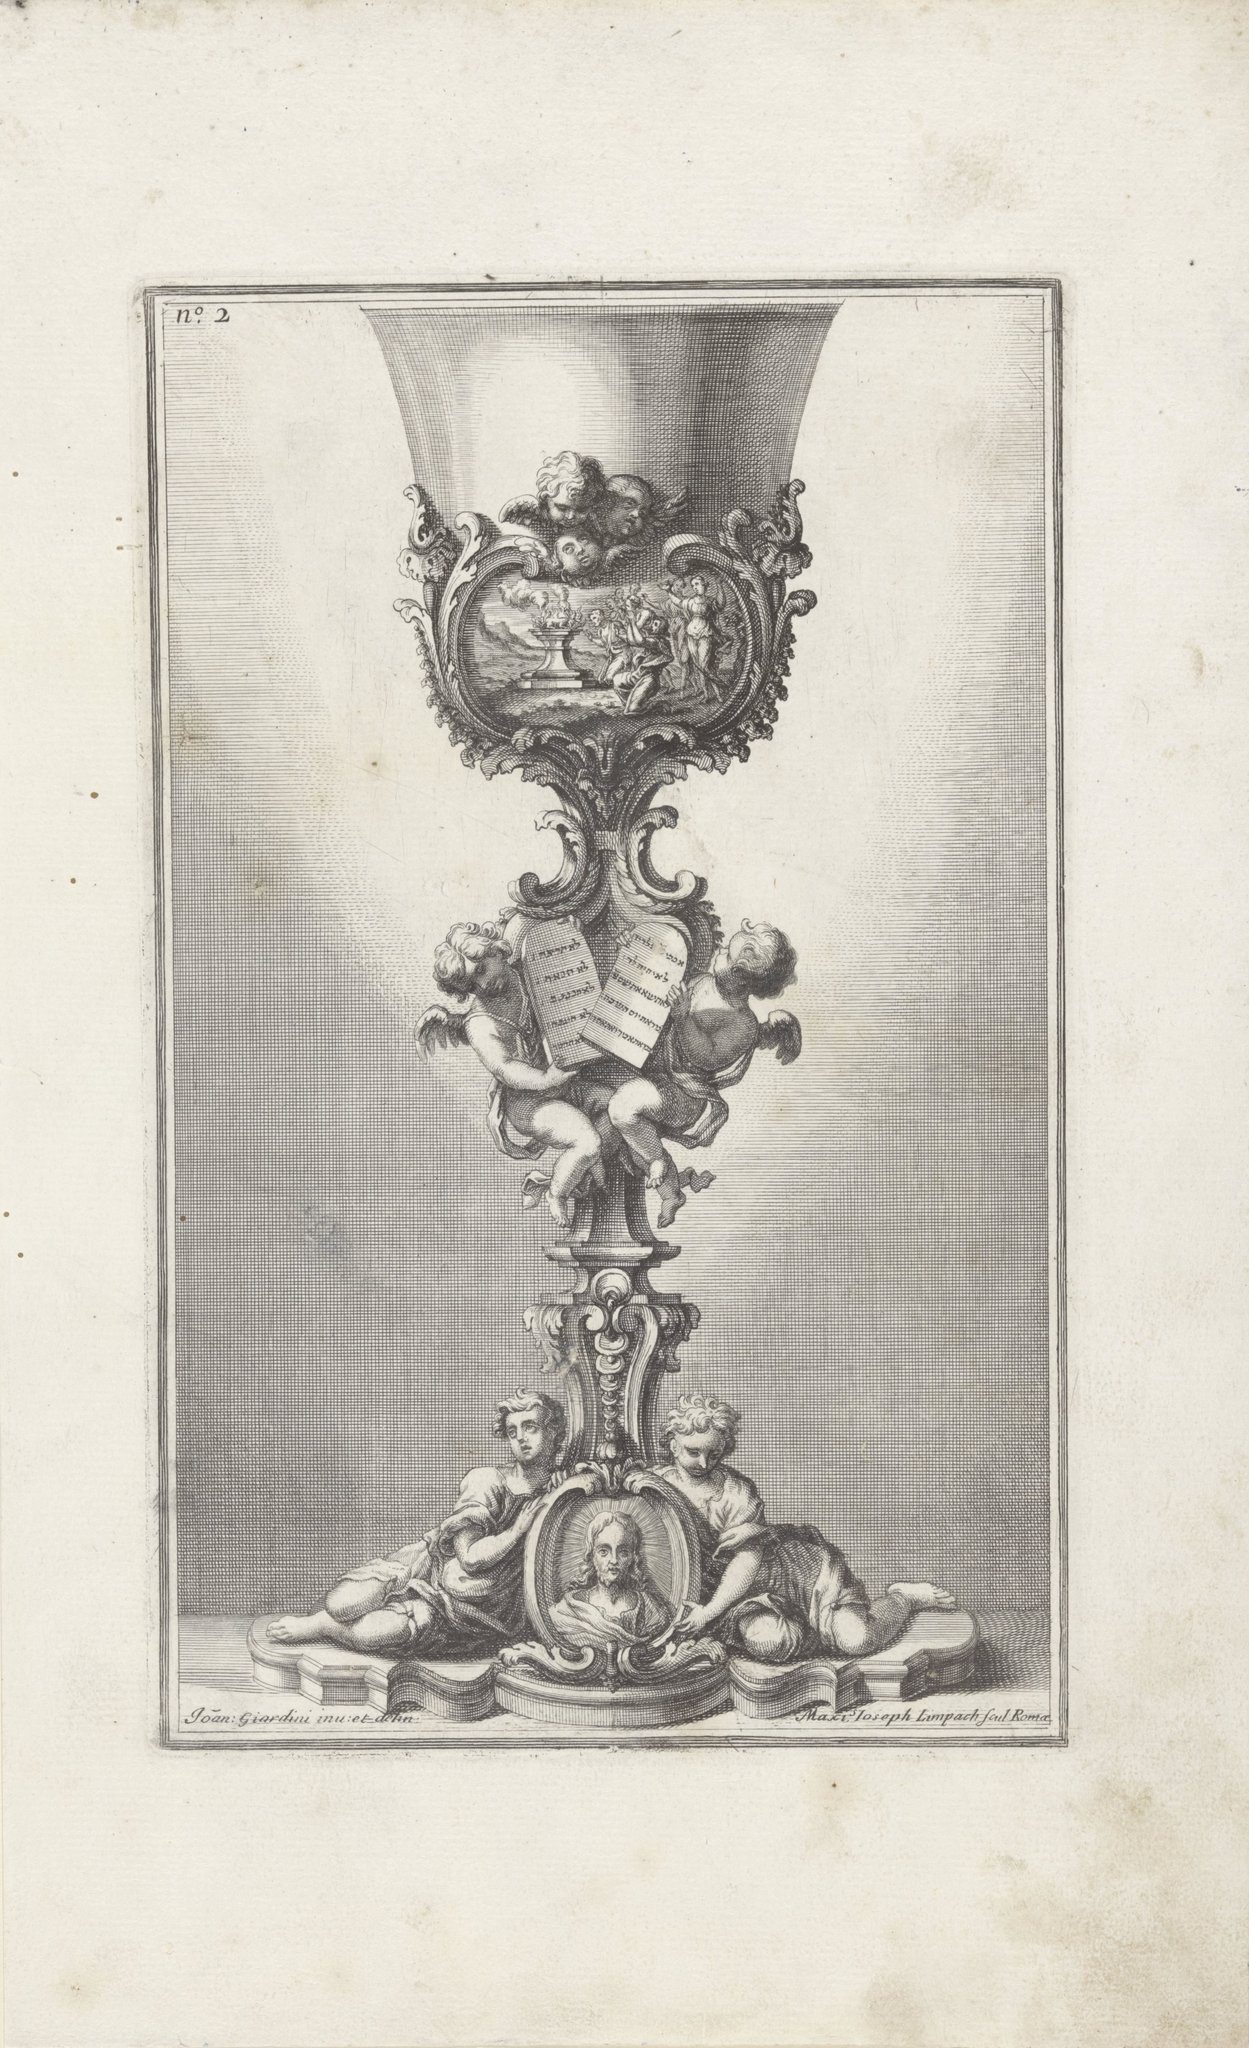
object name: ornament print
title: Disegni diversi inventati e delineati da Giovanni Giardini da Forlì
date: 1714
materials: paper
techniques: etching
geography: vatican city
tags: chalice, christ, cupids: 'amores', 'amoretti', 'putti', sacrifice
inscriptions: collector's mark: Lugt 2228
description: Prent maakt deel uit van een reeks van 100 ornamentprenten naar ontwerp van Giovanni Giardini.